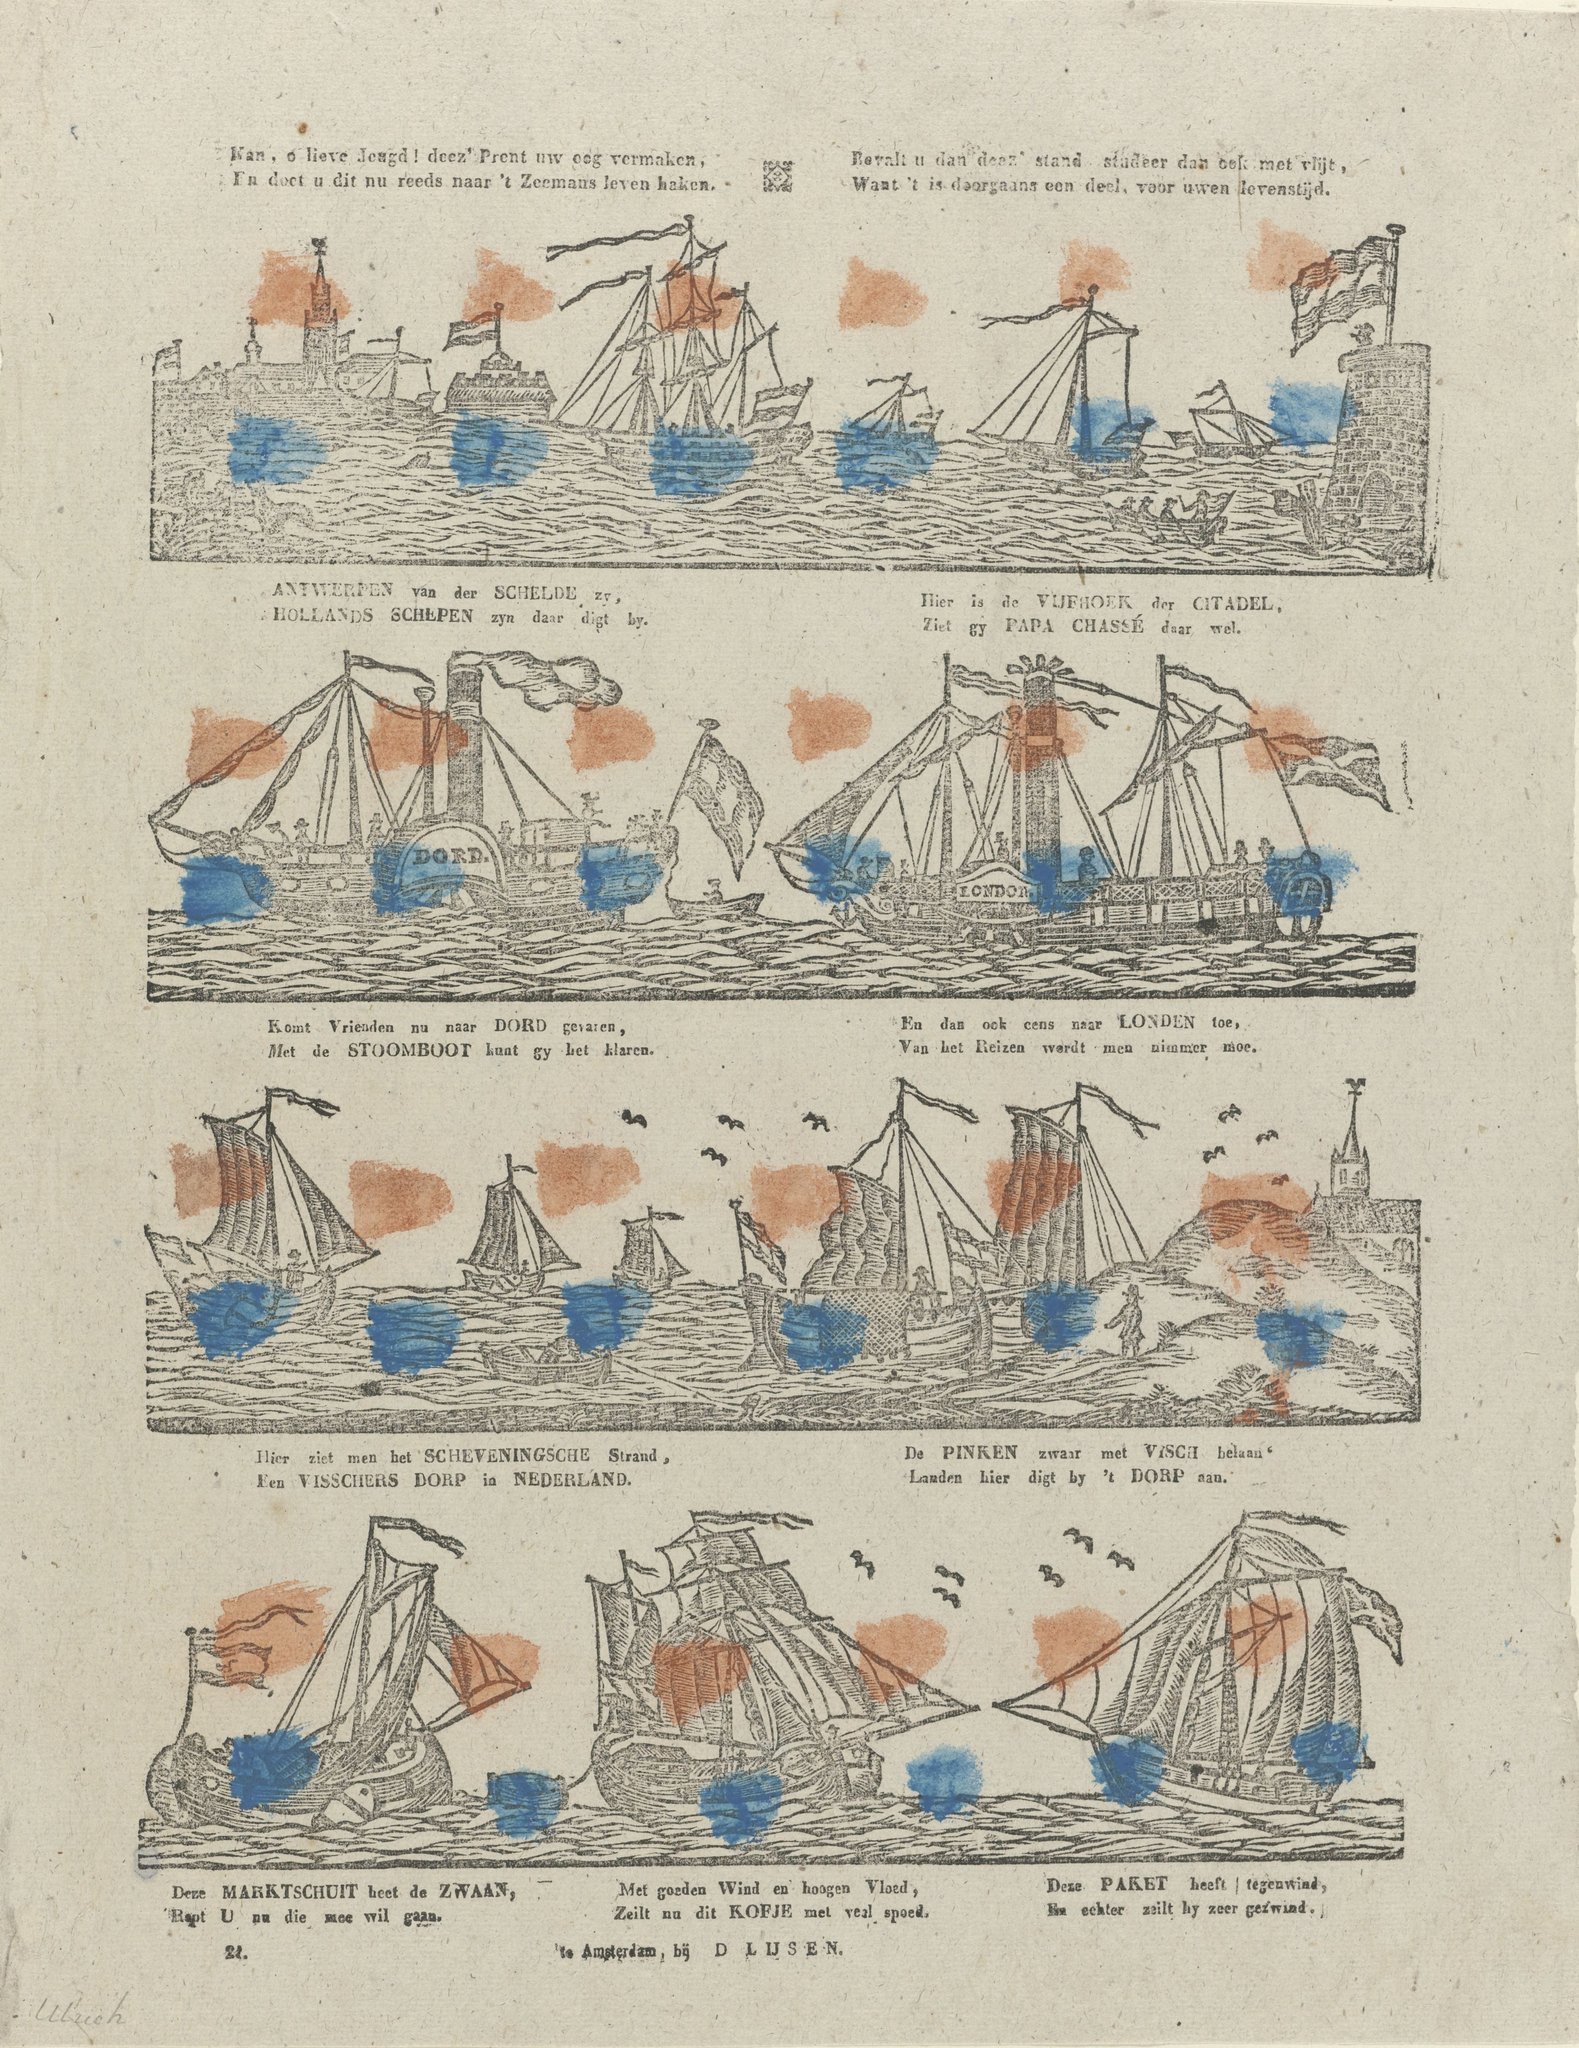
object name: print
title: Kan, o lieve jeugd! deez' prent uw oog vermaken, / En doet u dit nu reeds naar 't zeemans leven haken. / Bevalt u dan deez' stand studeer dan ook met vlijt, / Want 't is doorgaans een deel, voor uwen levenstijd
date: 1836-1849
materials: paper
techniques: colour, letterpress printing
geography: rotterdam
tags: sailing-ship, sailing-boat, ships (in general)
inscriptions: collector's mark: Lugt 2760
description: Blad met 4 horizontale rijen met voorstellingen van schepen. Onder elke voorstelling een vier- of zesregelig. Genummerd linksonder: 21.